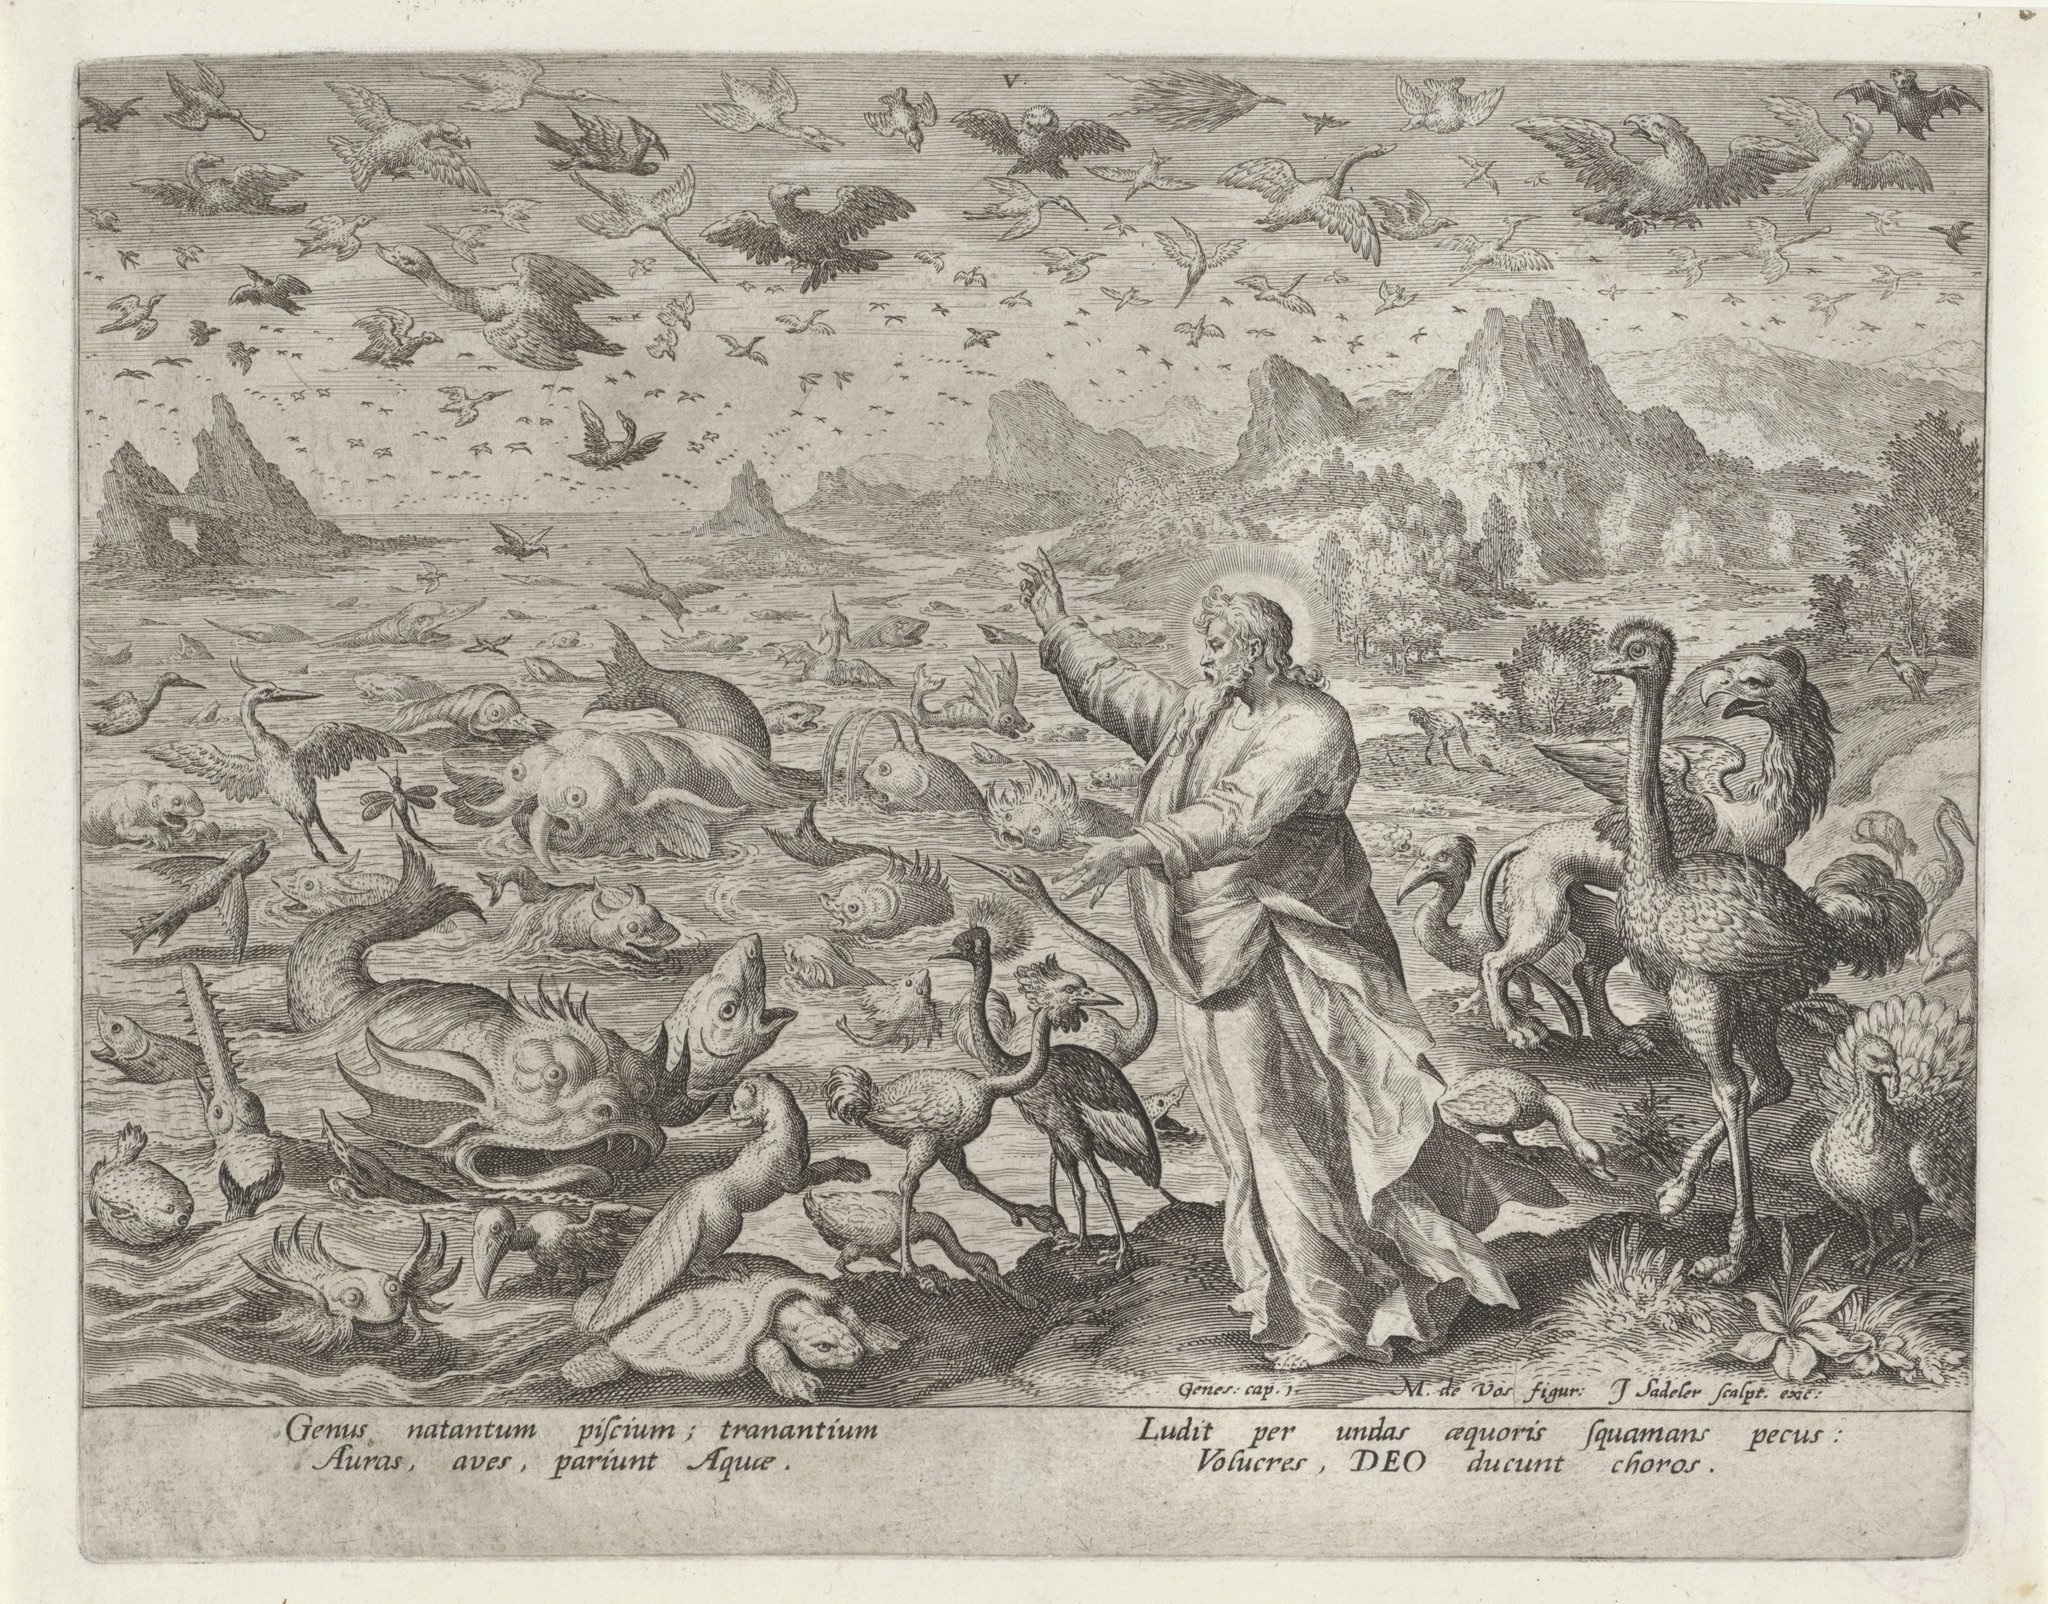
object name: print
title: Schepping van de vogels en de zeedieren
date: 1588-1600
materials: paper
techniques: engraving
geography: antwerp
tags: tortoises, turtles, birds, fishes, god the father as bearded old man, usually with crown or tiara or sceptre and/or globe, creation of the animals ~ genesis, swimming mammals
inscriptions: collector's mark: Lugt 240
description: God de Vader staat op de voorgrond en heft zijn armen op. Voor hem zwemmen zeedieren in het water. Op het land en in de lucht verschillende vogels. Op de vijfde dag van de schepping schiep God de vogels in de lucht en de dieren in het water. De prent heeft een Latijns onderschrift.